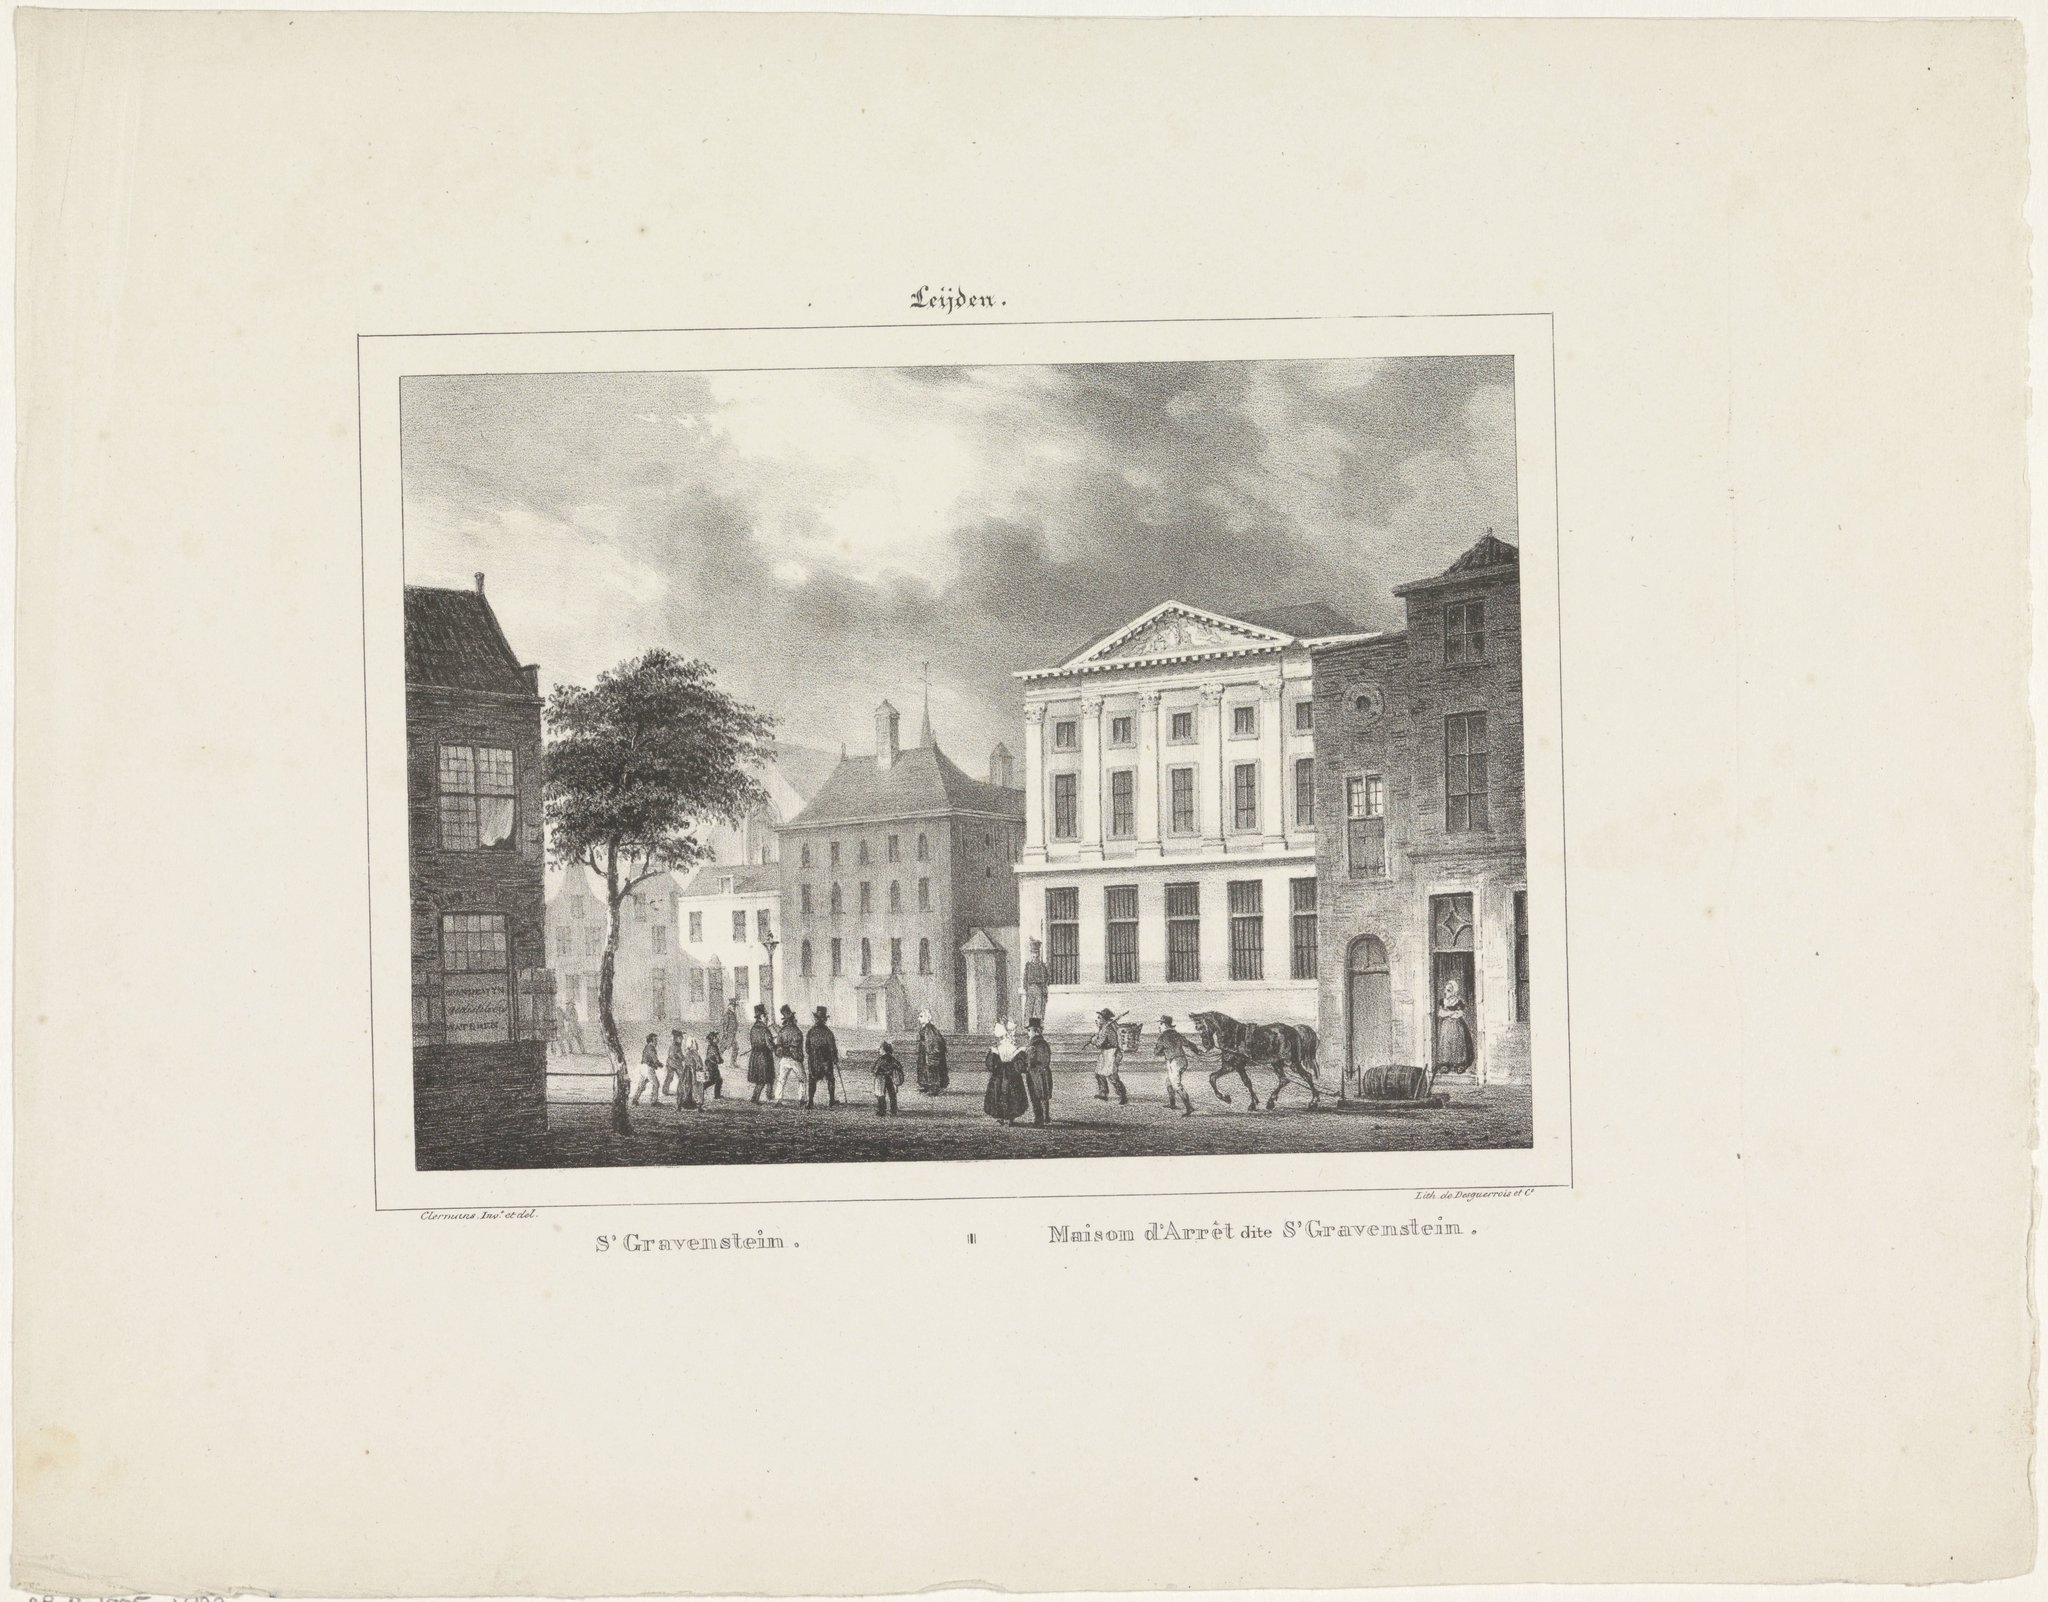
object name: print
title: S'Gravenstein. - Maison d'Arrêt dite S'Gravenstein.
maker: j.b. clermans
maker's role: print maker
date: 1826-1839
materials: paper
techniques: lithograph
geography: amsterdam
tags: prison, jail (+ court building), city-view, and landscape with man-made constructions (+ city(-scape) with figures, staffage), leiden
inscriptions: collector's mark: Lugt 2228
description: Voor de Graventeen, een gerechtsgebouw en gevangenis, staat een soldaat op wacht. Op het plein daarvoor staan en lopen figuren. In het gebouw rechts van de Gravensteen staat een vrouw in de deuropening.